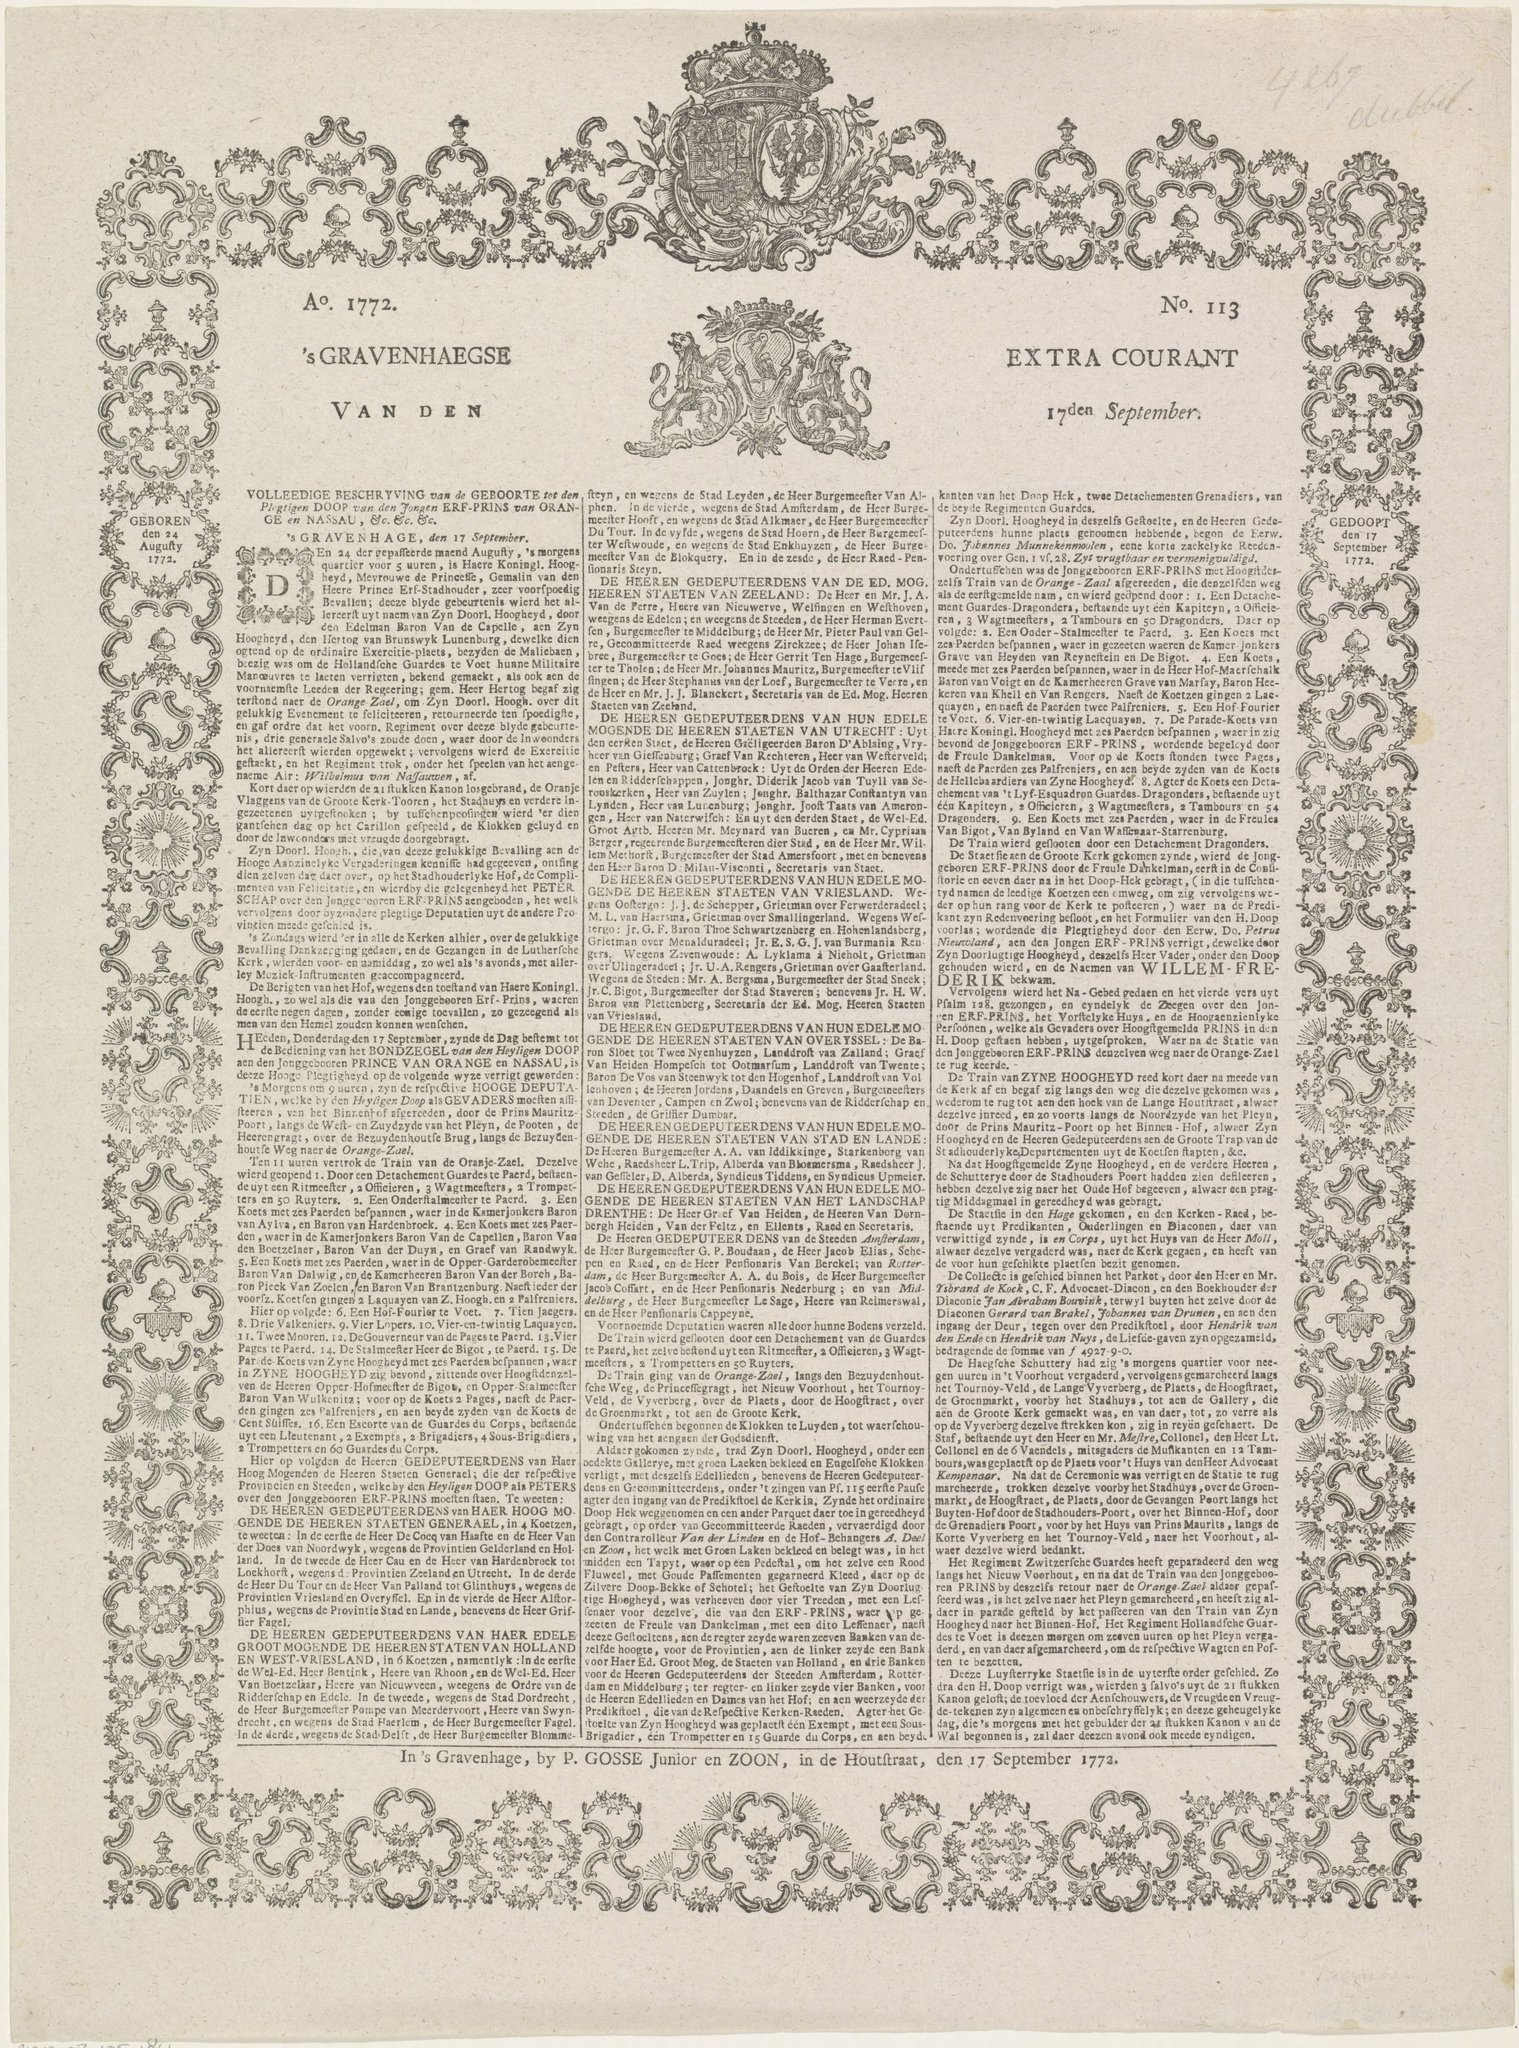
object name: newspaper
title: 's Gravenhaegse Extra Courant Van den 17den September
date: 1772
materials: paper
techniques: letterpress printing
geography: the hague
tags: the hague, berlin, william i of the netherlands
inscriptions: date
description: Courant ter ere van de geboorte van Willem I Frederik op 24 augustus 1772. Drie kolommen met Nederlandse tekst in boekdruk. Geheel in een geornamenteerde rechthoek.